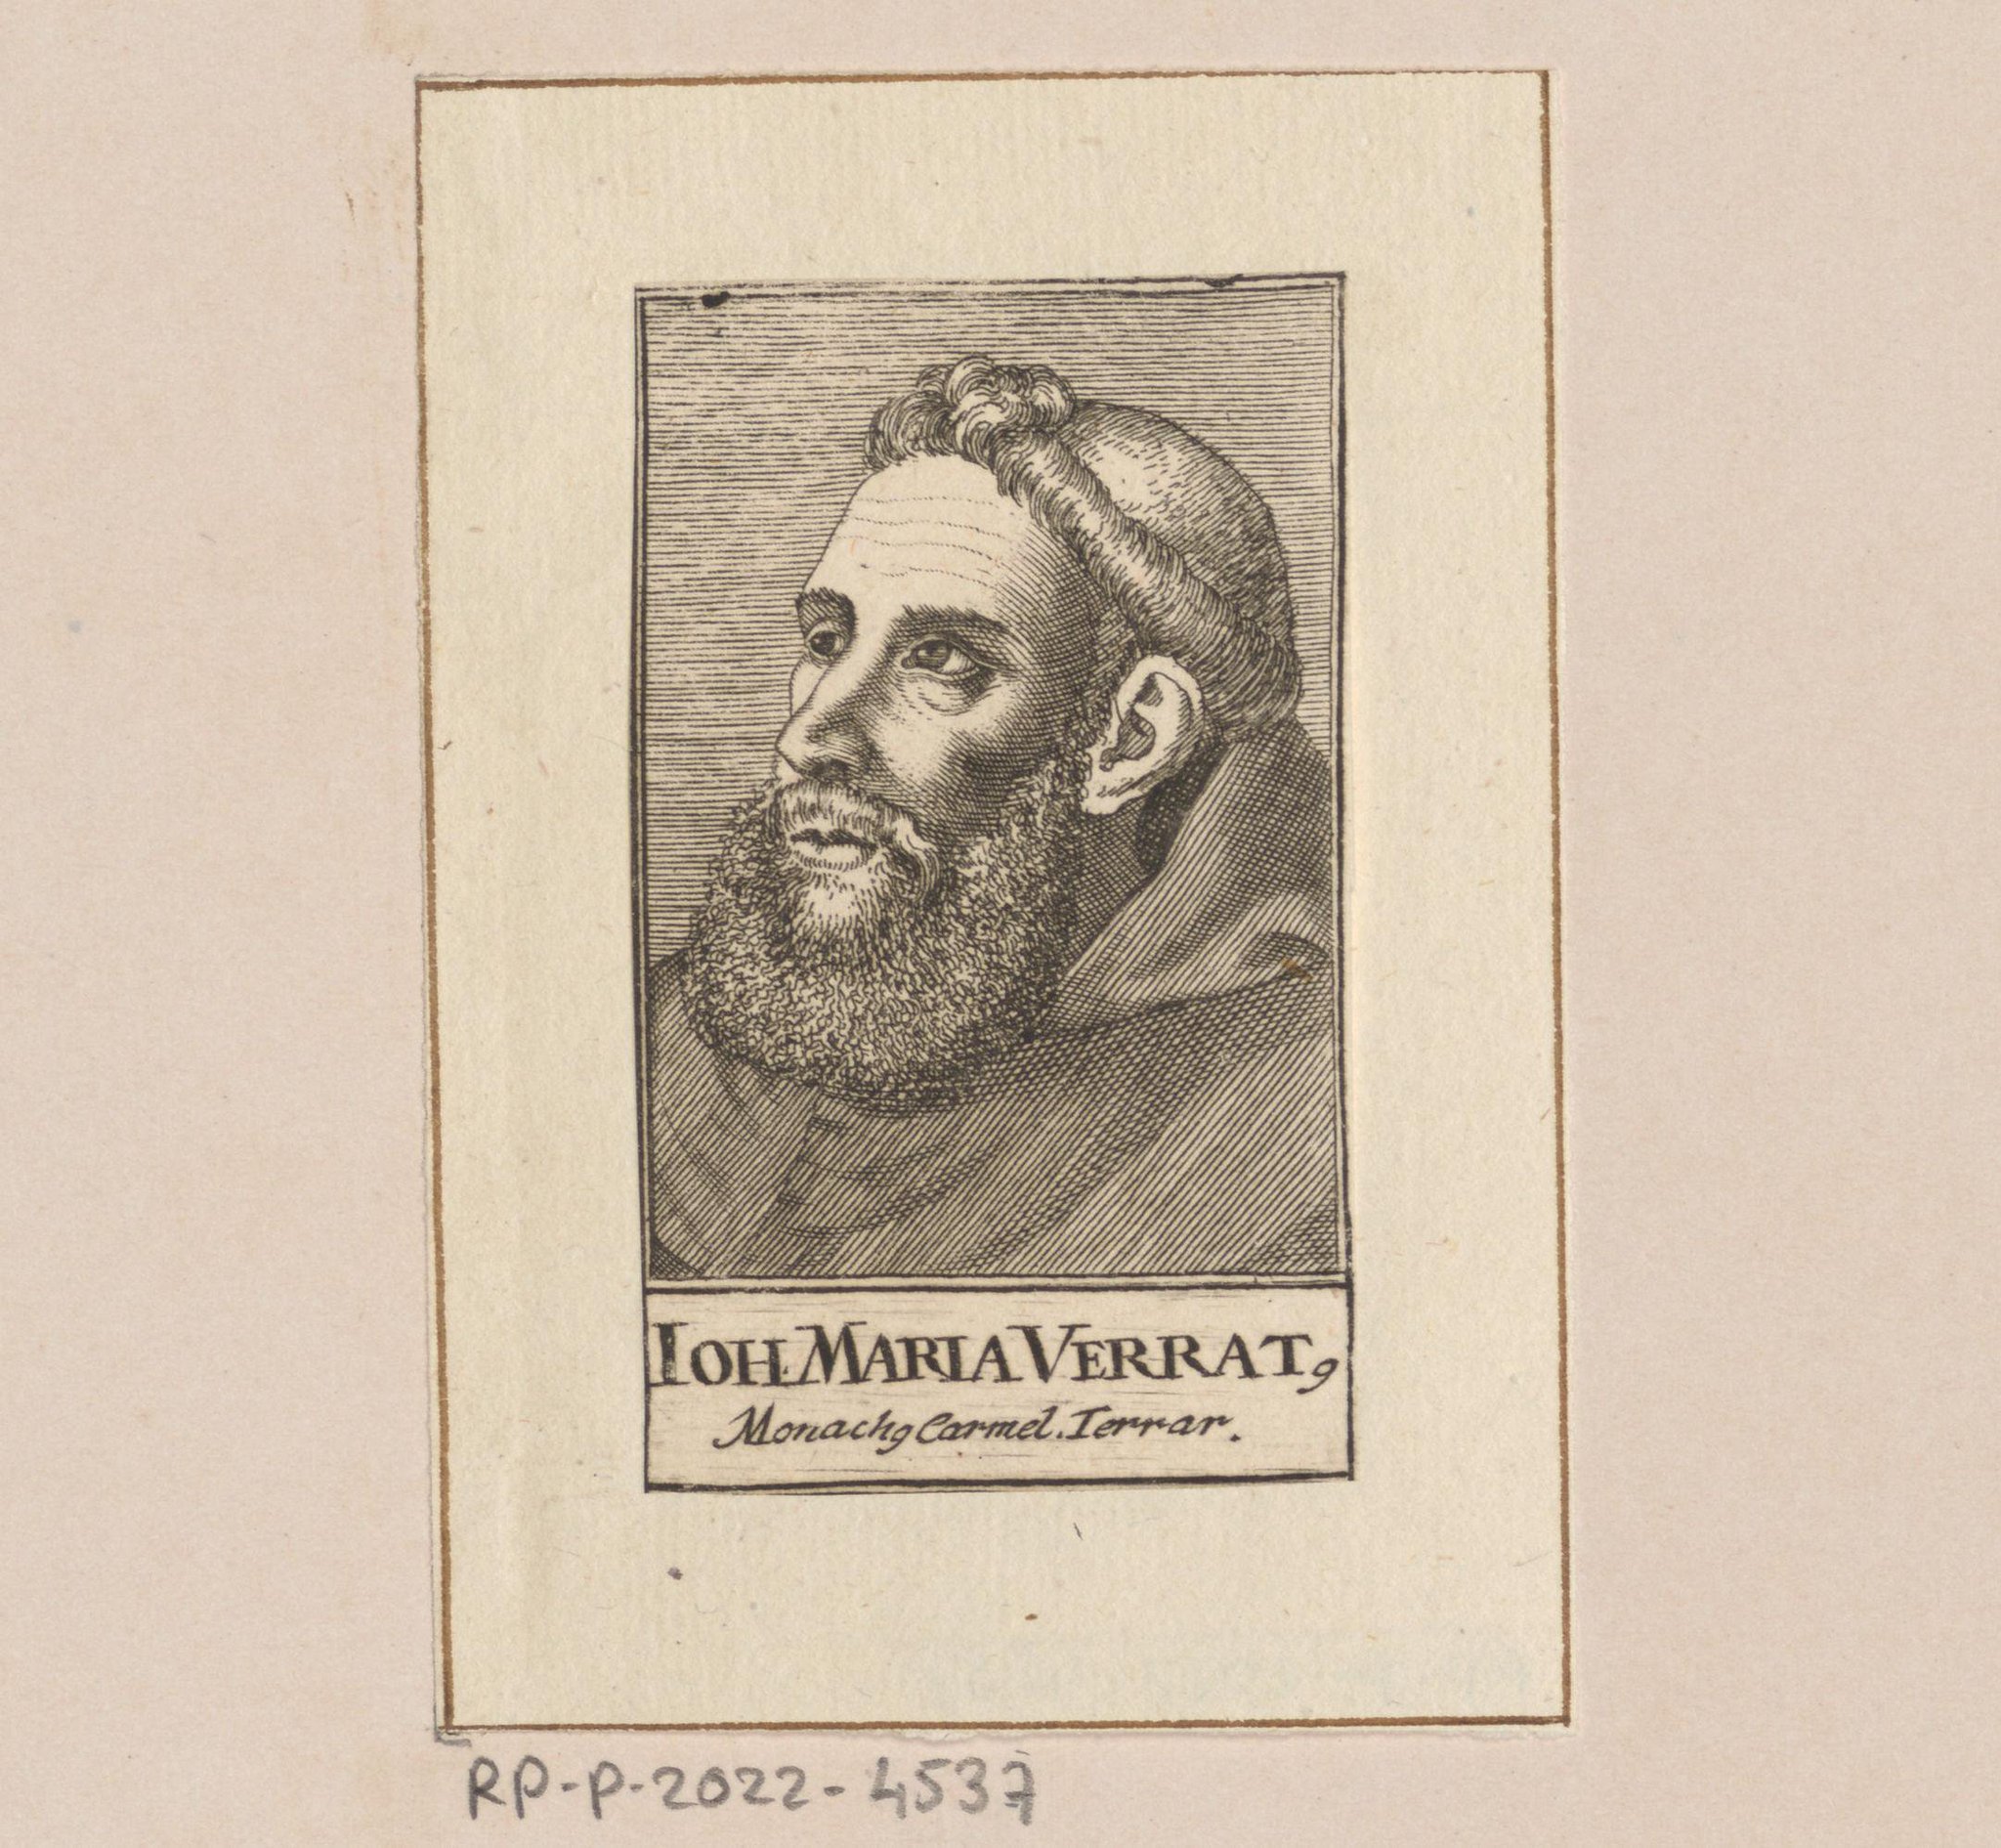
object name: print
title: Portret van Johannes Maria Verrati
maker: Anonymous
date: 1688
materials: paper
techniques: engraving, etching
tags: theologian, historical persons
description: Prent waarschijnlijk uit: Freher, Paul. Theatrum Virorum Eruditione Clarorum Tomus Posterior. Neurenberg: Johann Hofmann, 1688.